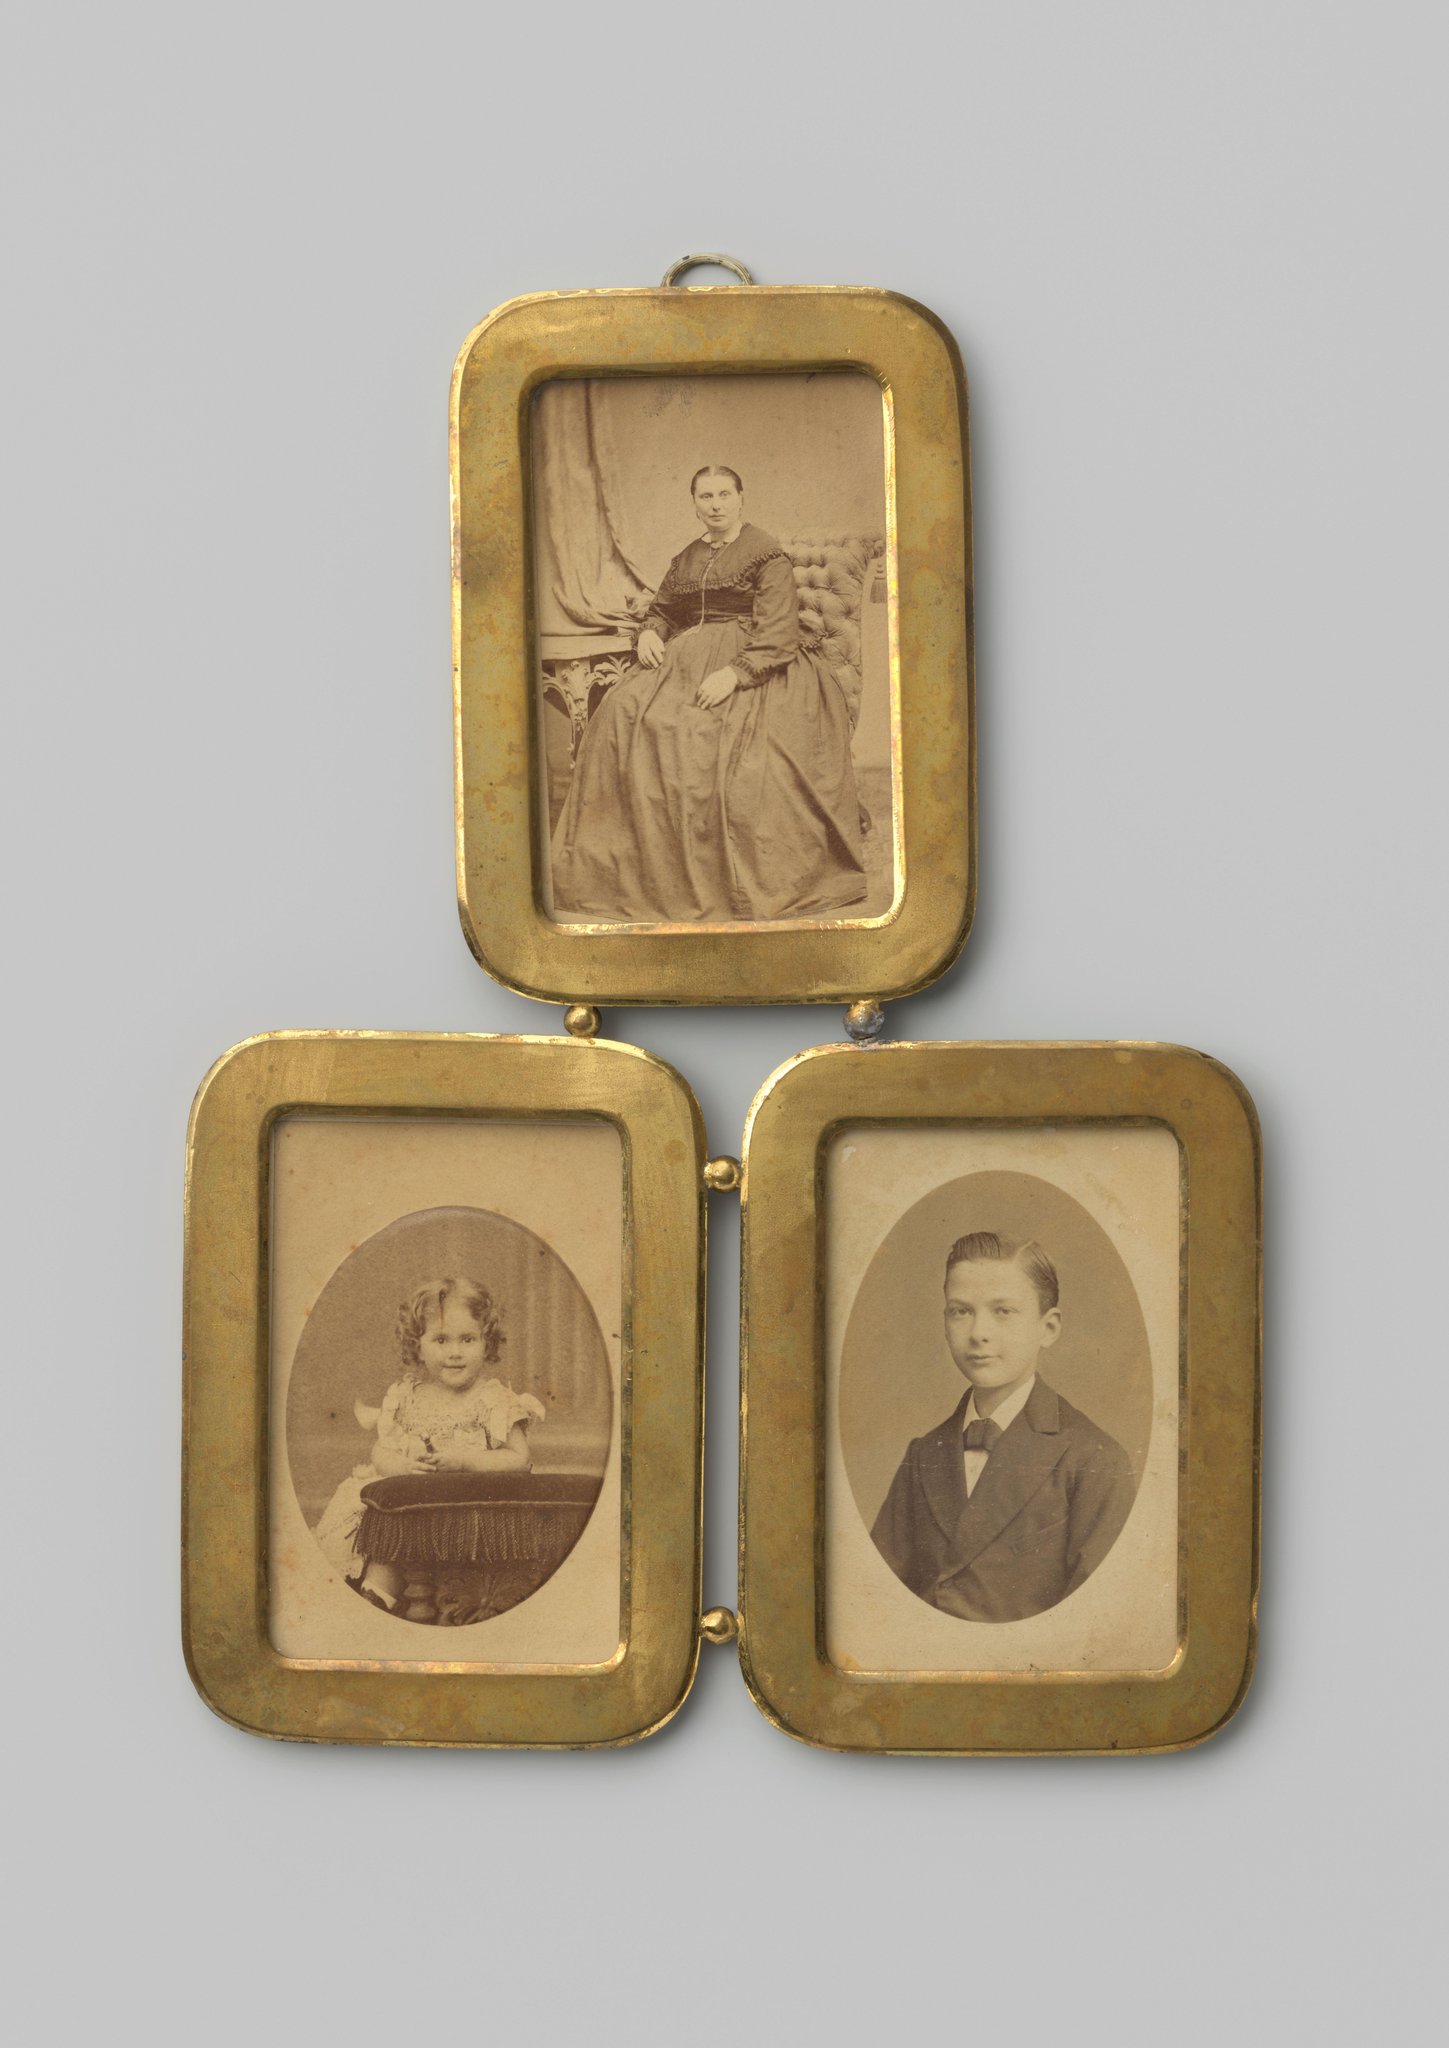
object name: frame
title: Drie portretten van een onbekende vrouw, een onbekend meisje en een onbekende jongen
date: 1866-1896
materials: cardboard, glass, metal, paper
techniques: albumen print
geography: amsterdam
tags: adult woman, boy (child between toddler and youth), anonymous historical person portrayed, toddler (female), amsterdam, arnhem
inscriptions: inscription: ‘L.R. Werner/ voorheen/ P. Carstensen/ Nieuwendyk H.201/ Amsterdam/ Voor nabestellingen blijft de Plaat bewaard.’, inscription: ‘from Nell/ for Barbara/ her first nurse’, inscription: ‘Atelier/ van/ C.E. Westerborg/ Photograaf/ Arnhem/ Voor nabestellingen worden alle/ negatieven bewaard.’, inscription: ‘L.R. Werner/ voorheen/ P. Carstensen/ Nieuwendyk H.150./ Amsterdam’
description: Drie rechthoekige lijsten van metaal, die aan elkaar geschakeld zijn (één boven, twee onder). In de bovenste lijst een portret van een vrouw; onder links een klein meisje (kleuter), onder rechts een jongen.